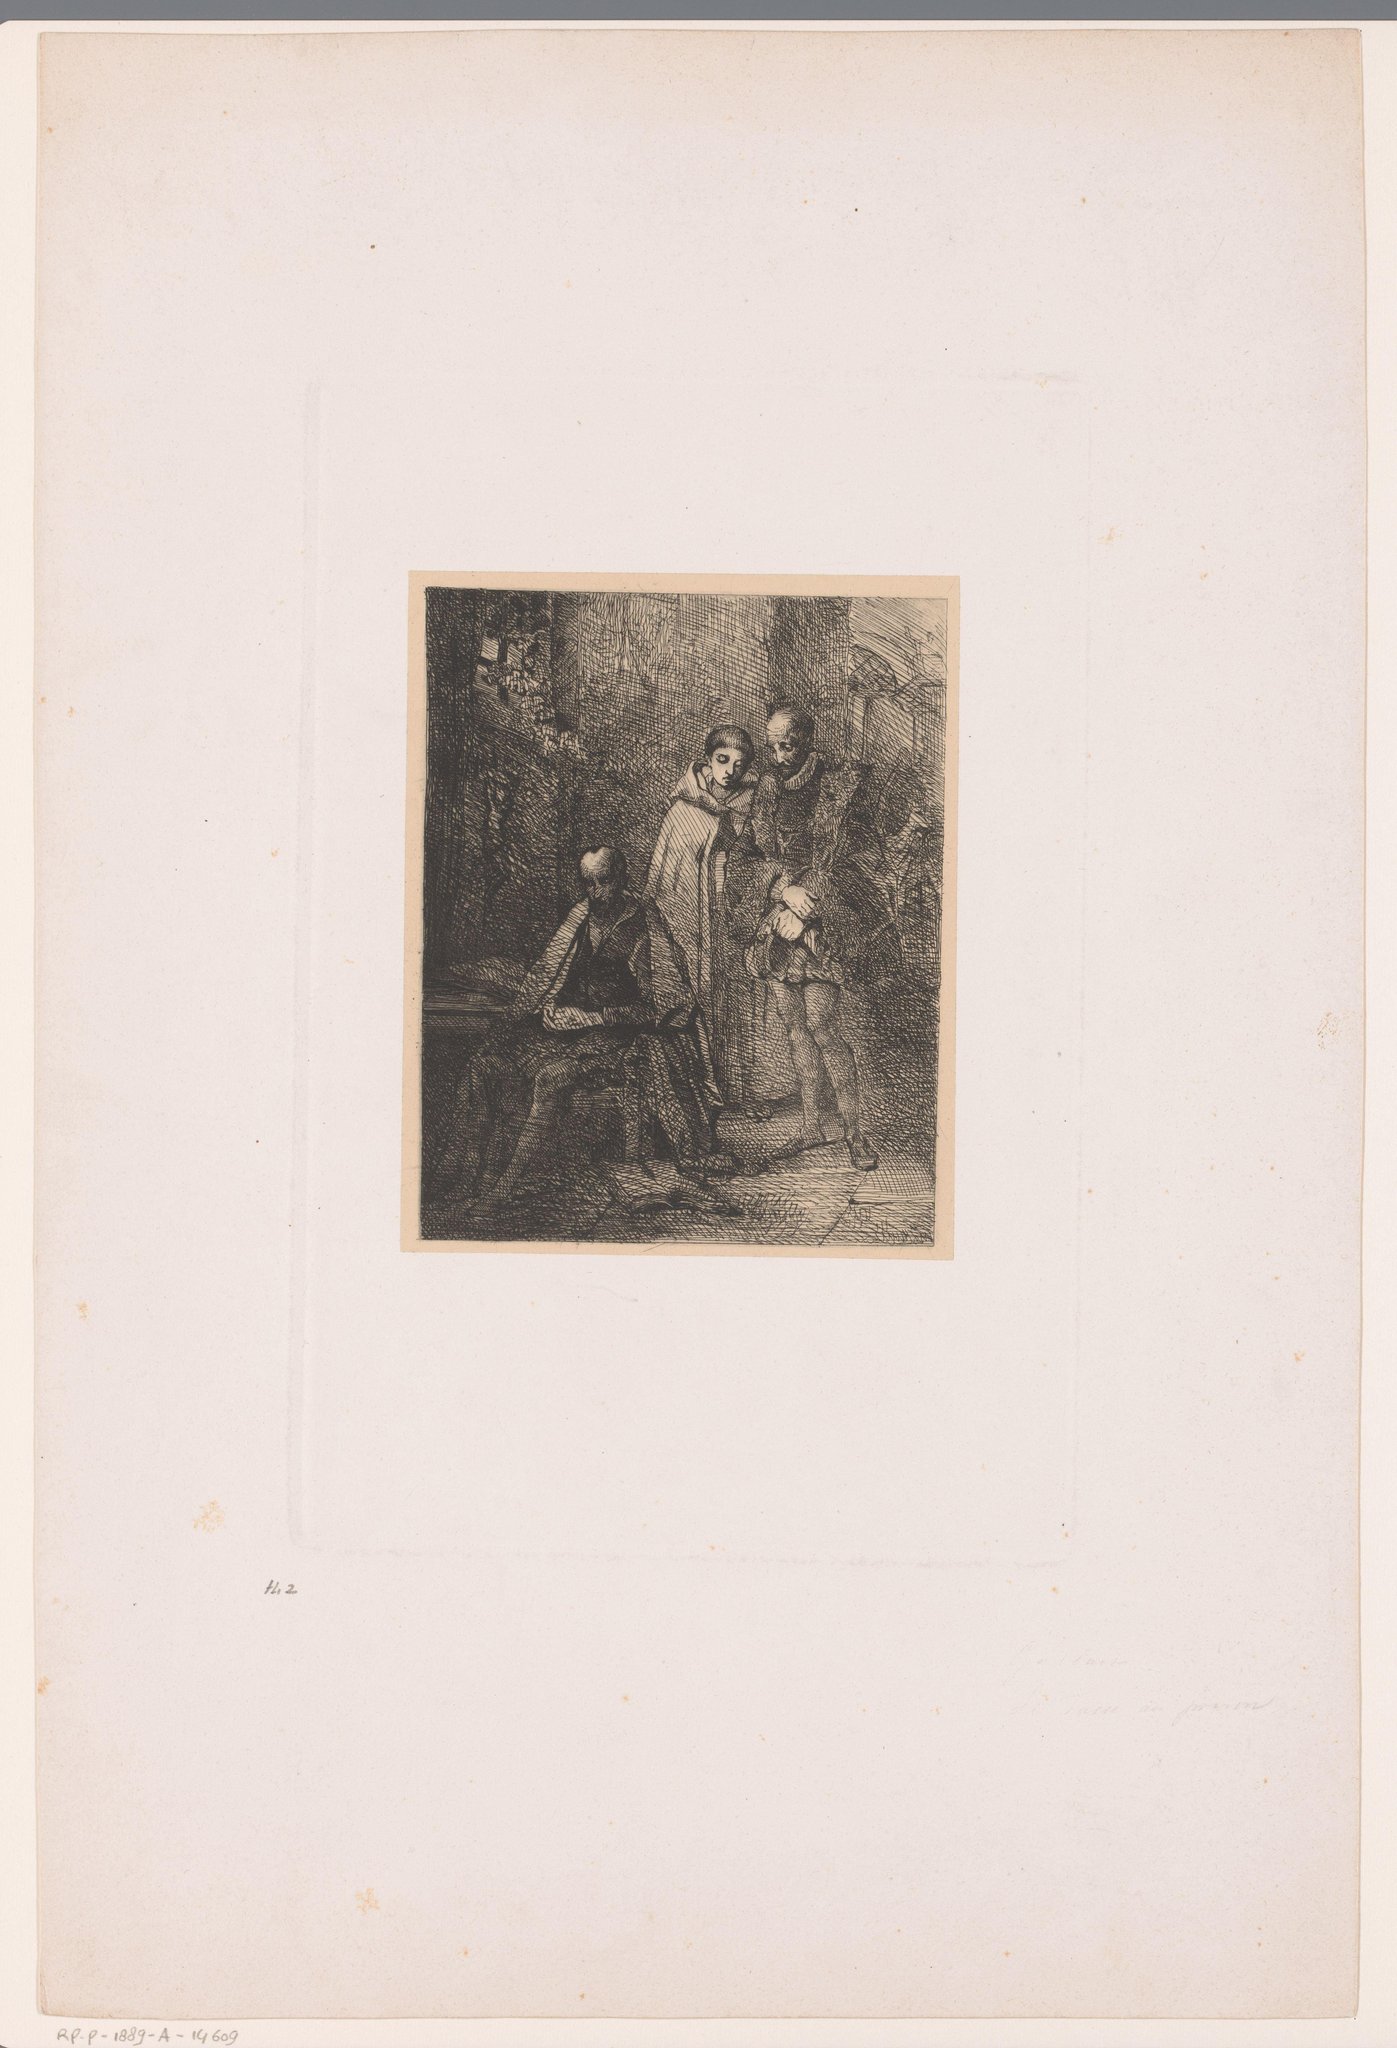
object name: print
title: Michel Eyquem de Montaigne bezoekt Torquato Tasso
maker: louis gallait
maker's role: draughtsman, painter, print maker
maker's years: 1810-1887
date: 1836-1837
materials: paper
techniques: etching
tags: torquato tasso, michel eyquem de montaigne, prison, jail, crucifix ~ personal devotion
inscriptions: collector's mark: Lugt 2228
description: De plaats waar de ontmoeting zich afspeelt is mogelijk een gevangenis, klooster of gekkenhuis.